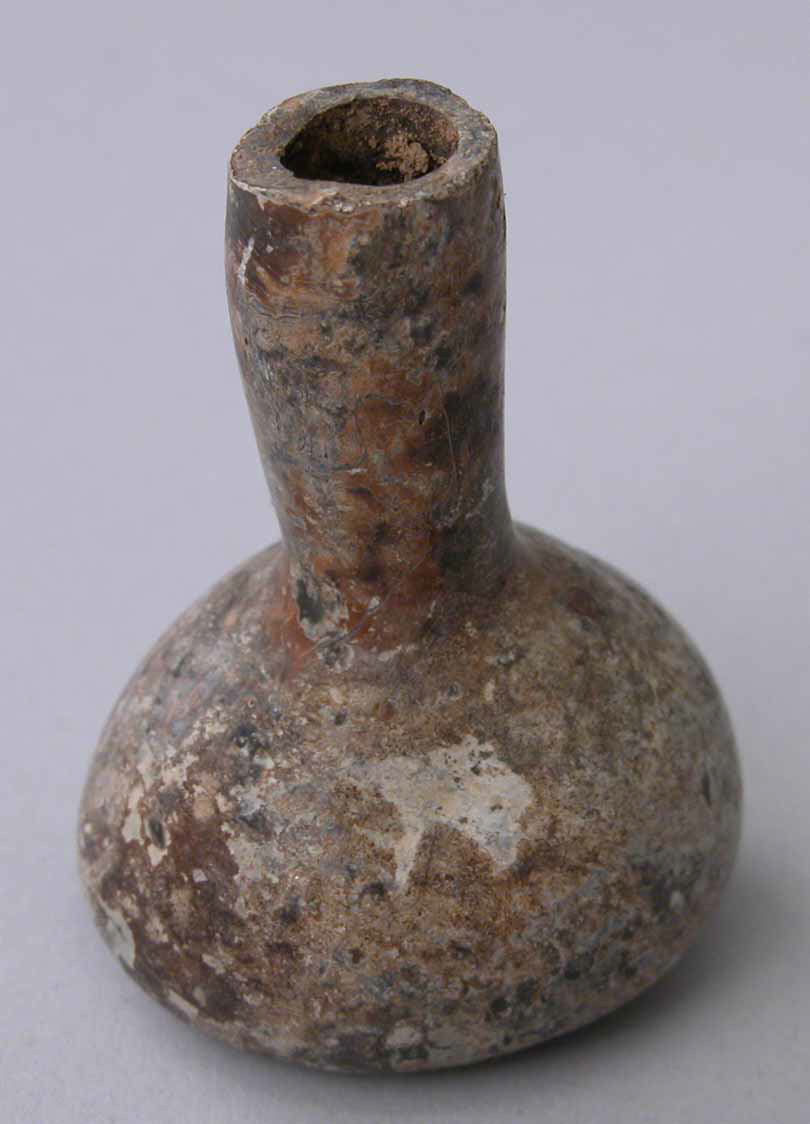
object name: bottle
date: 601-800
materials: glass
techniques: glassblowing, tooling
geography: iraq